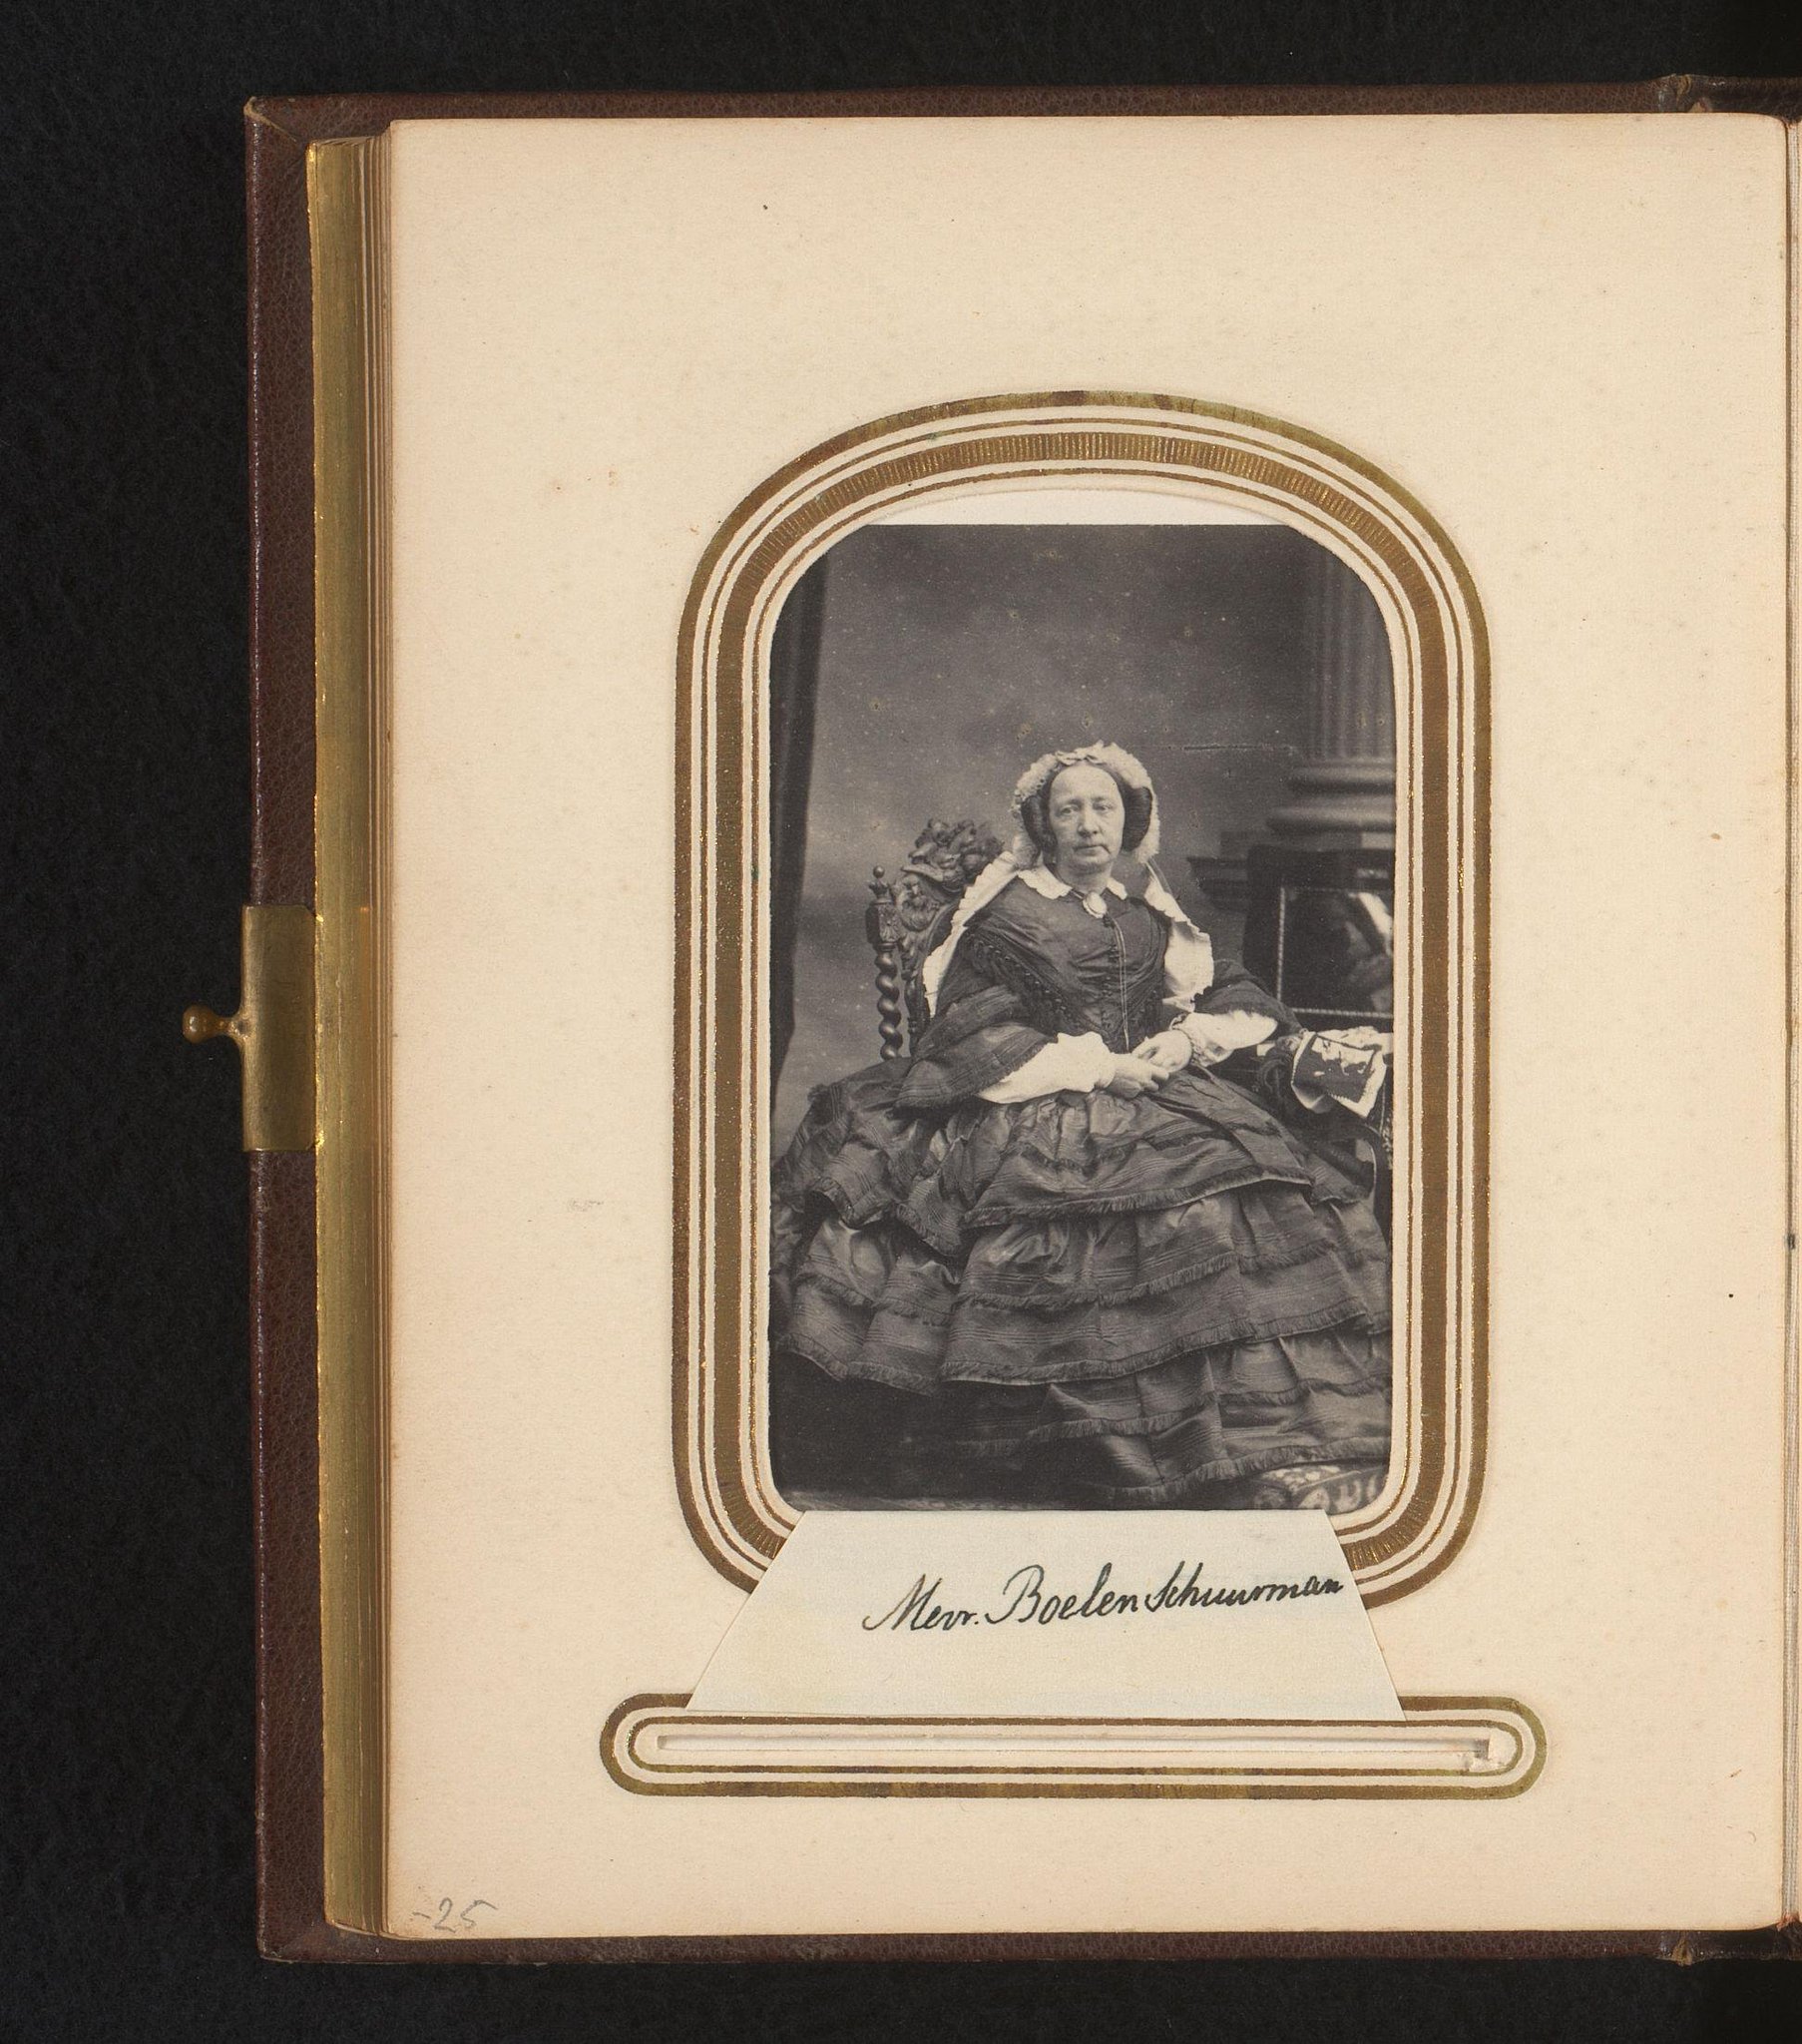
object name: photograph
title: Mevr. Boelen Schuurman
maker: louis wegner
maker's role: print maker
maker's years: 1816-1864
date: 1862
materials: cardboard, paper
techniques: albumen print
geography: amsterdam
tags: haarlem, historical persons - bb - woman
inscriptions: address: ‘Prinsengracht BB 439/ AMSTERDAM’